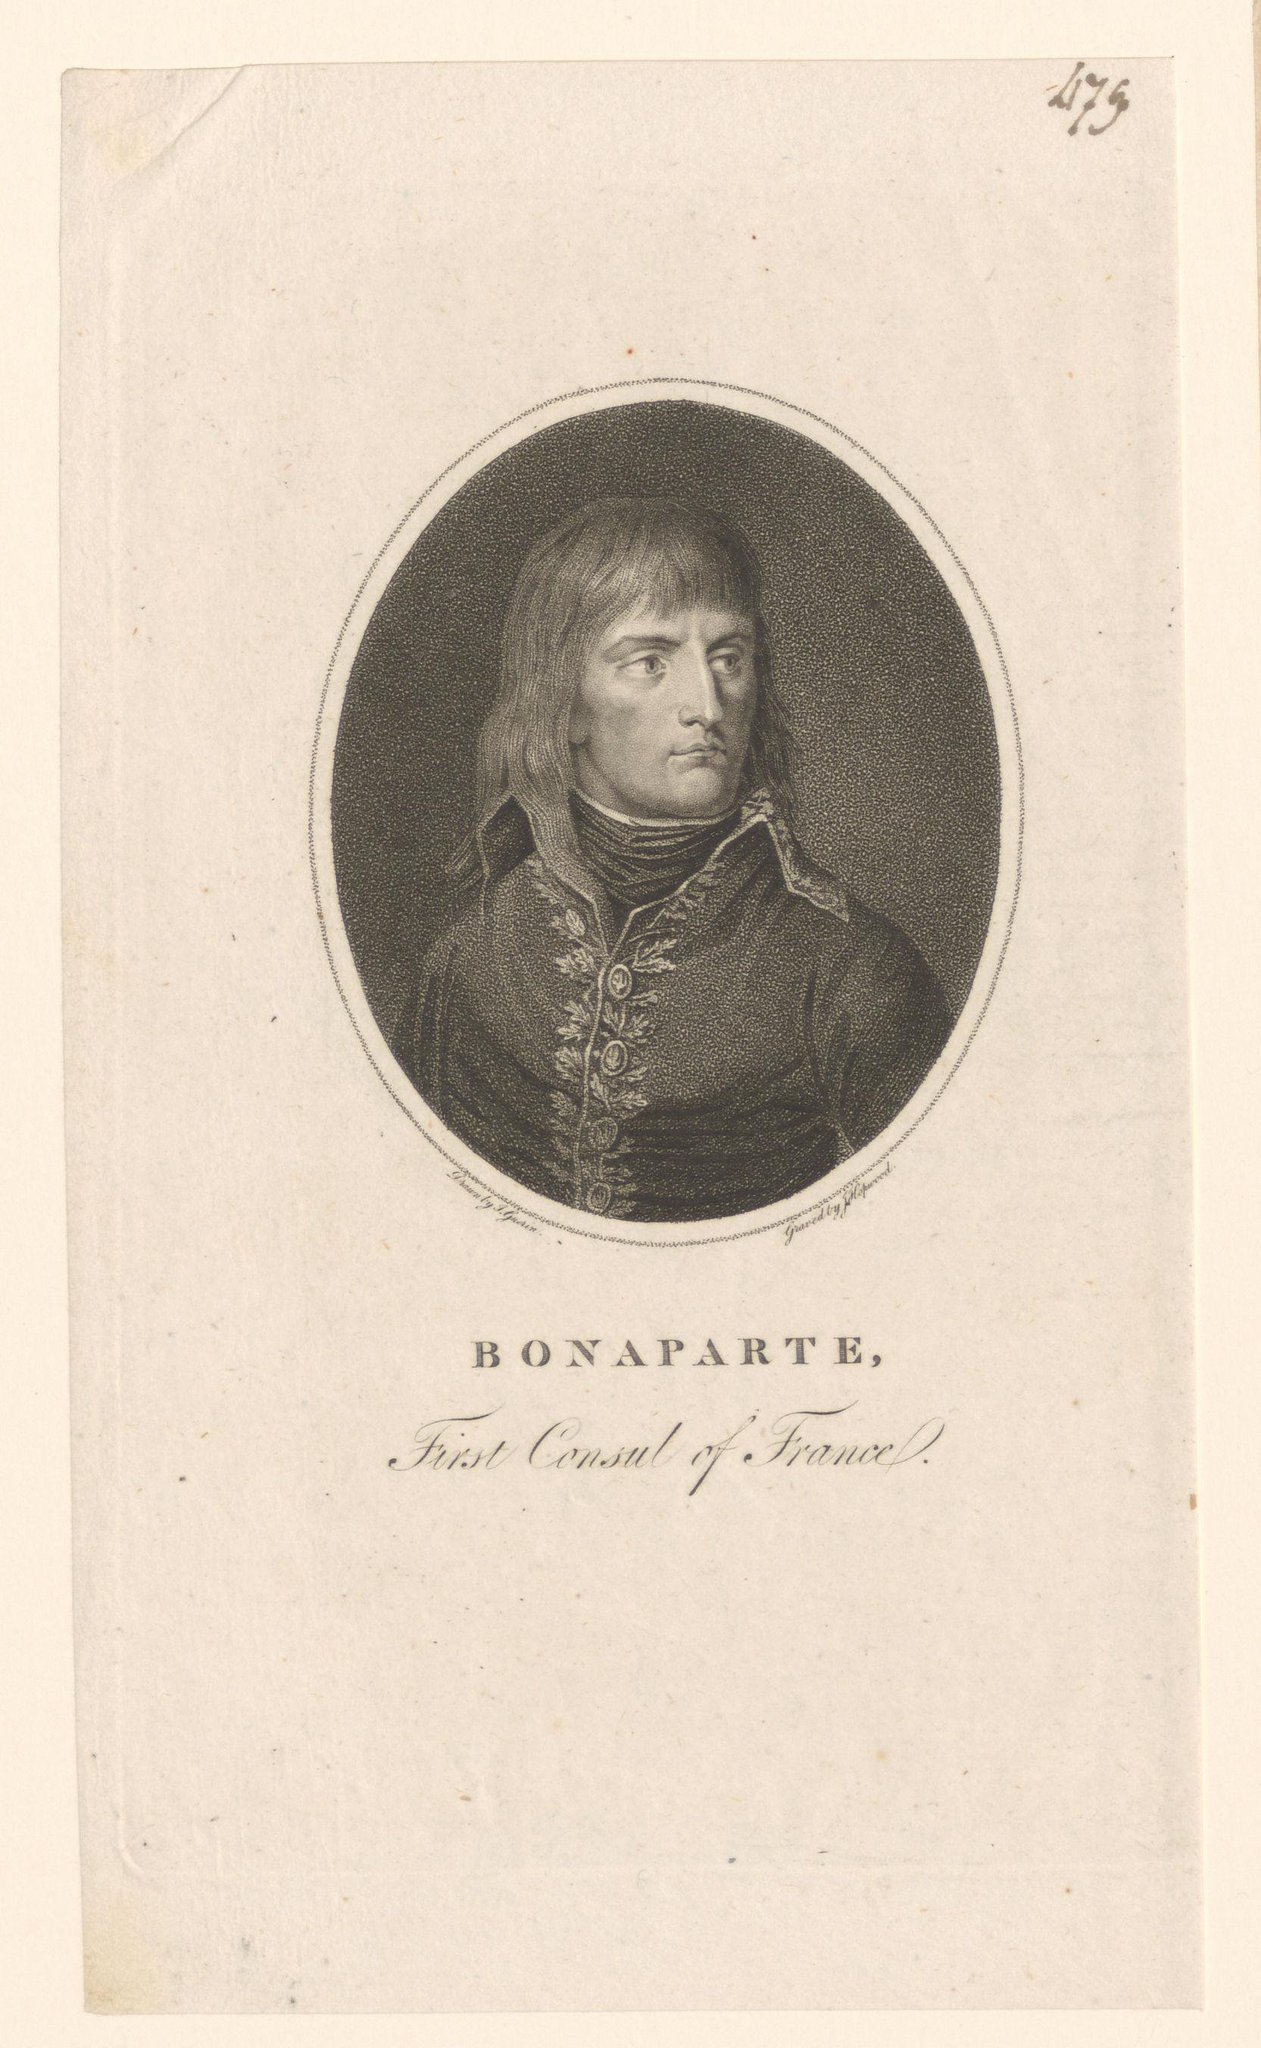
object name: print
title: Bonaparte, First Consul of France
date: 1799-1804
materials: paper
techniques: etching, engraving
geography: england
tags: napoleon i (emperor of the french), historical persons, politician, e.g. party leader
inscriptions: collector's mark: Lugt 2228, inscription: ‘479’